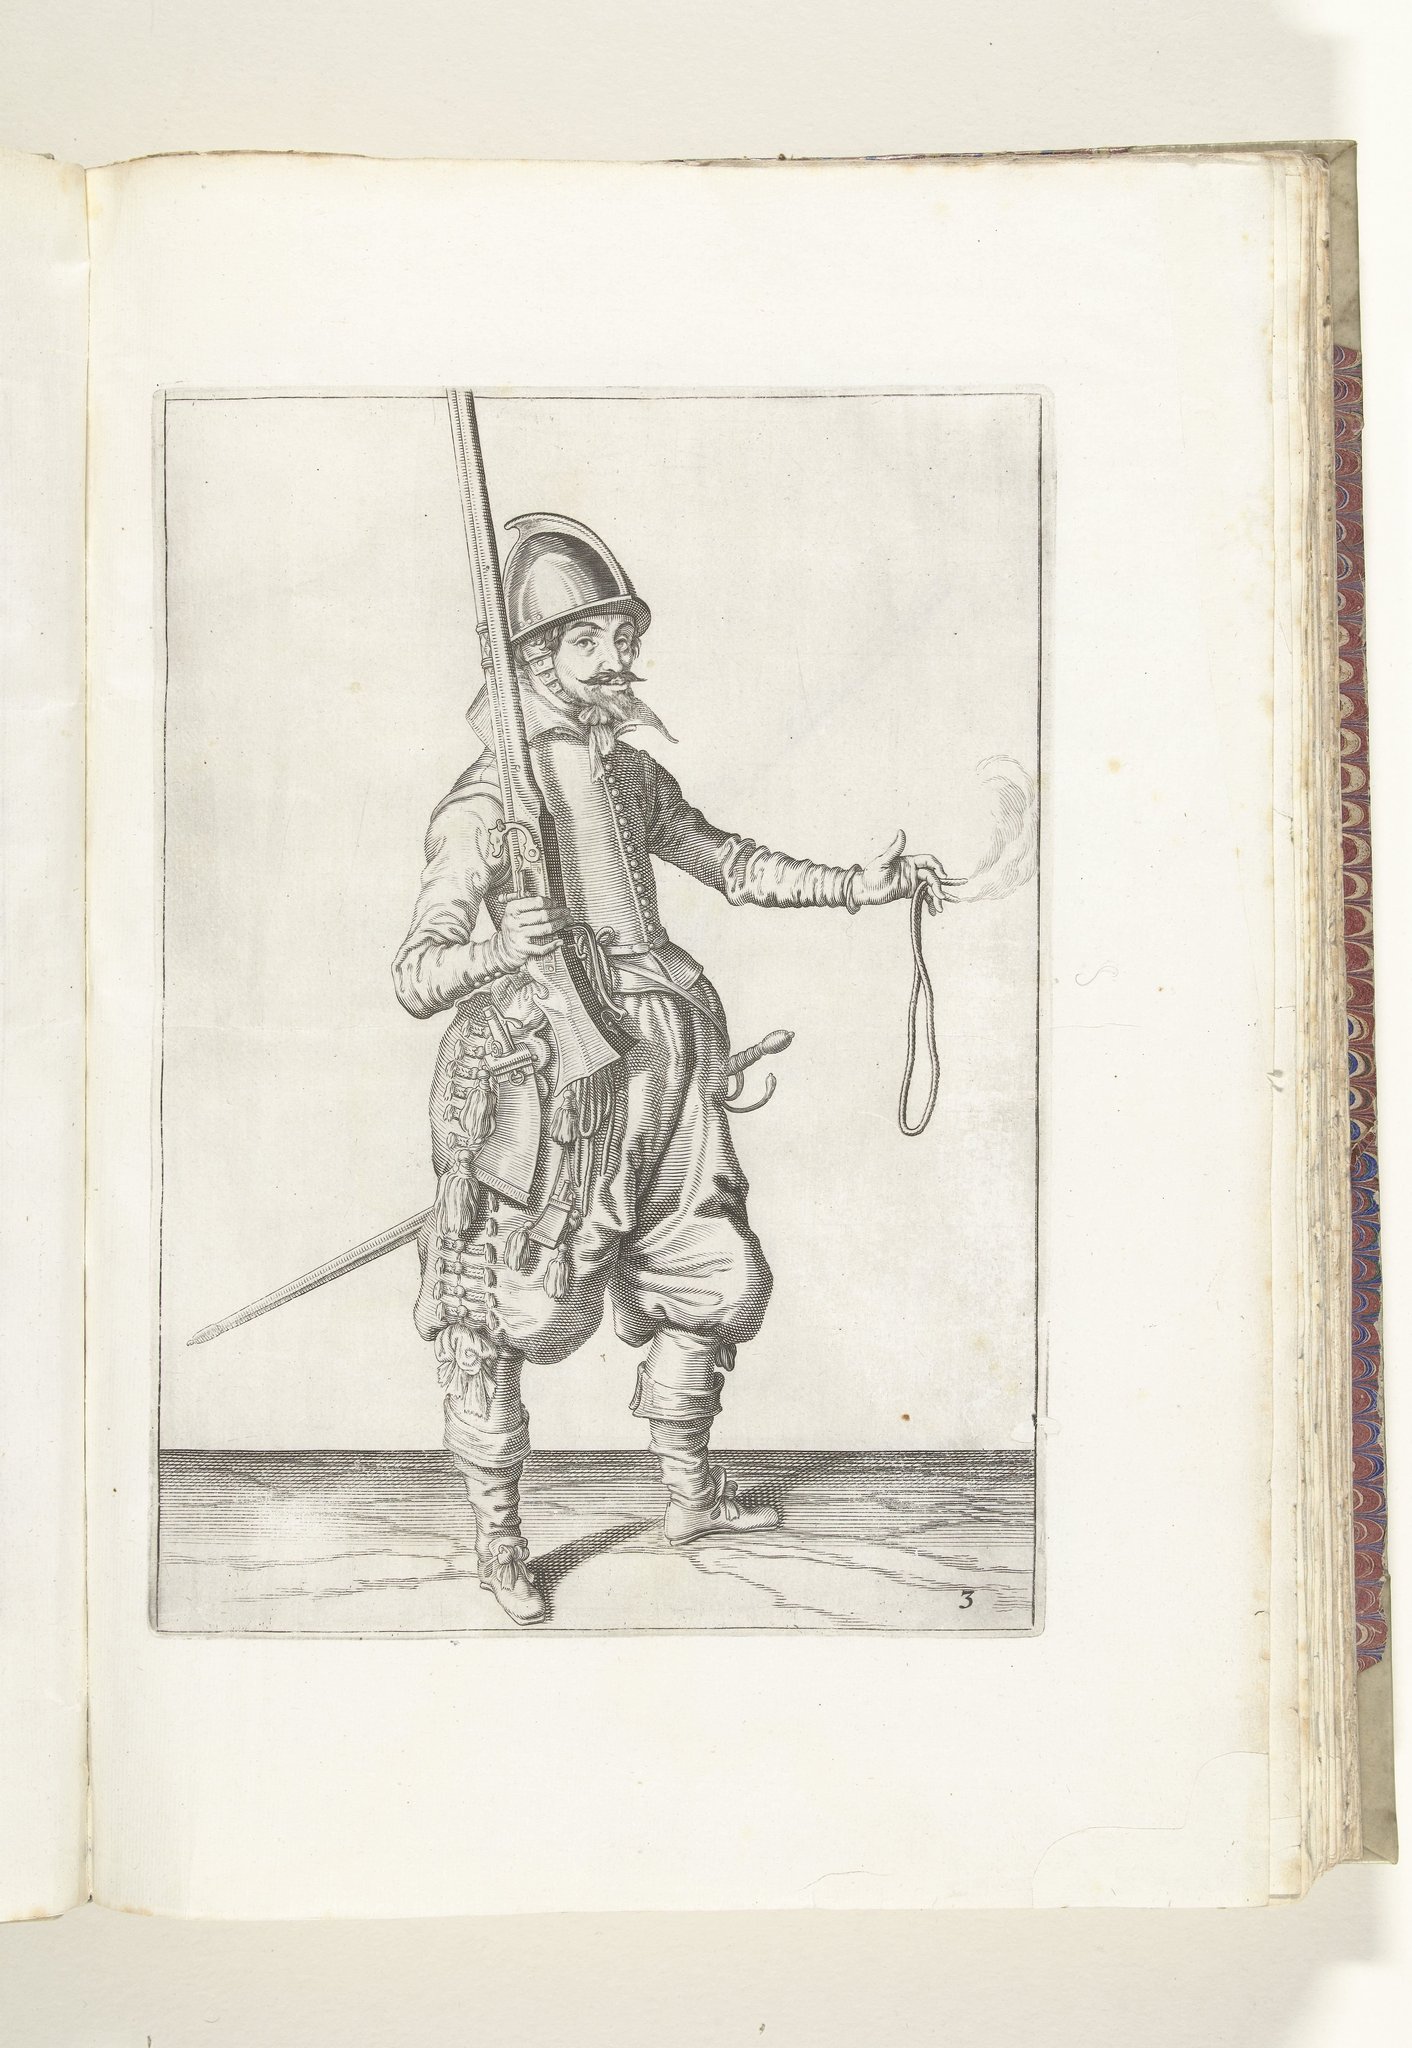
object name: print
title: Soldaat die zijn roer met zijn rechterhand rechtop vasthoudt, zijn linkerhand open om het wapen aan te nemen (nr. 3), ca. 1600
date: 1597-1607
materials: paper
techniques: engraving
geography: northern netherlands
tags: maurice (prince of orange), handling of weapons ~ military training, weapons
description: Een soldaat, ten voeten uit, naar rechts, die een roer (een bepaald type vuurwapen) met zijn rechterhand vasthoudt, de loop omhoog wijzend, alvorens zijn wapen over te brengen naar zijn linkerhand (nr. 3), ca. 1600. In zijn uitgestoken linkerhand een brandende lont. Plaat 3 in de instructies voor het hanteren van de roer. Onderdeel van de illustraties in: J. de Gheyn, Wapenhandelinghe van Roers Musquetten ende spiessen, Amsterdam, 1608. Krijgswezen rond 1600.